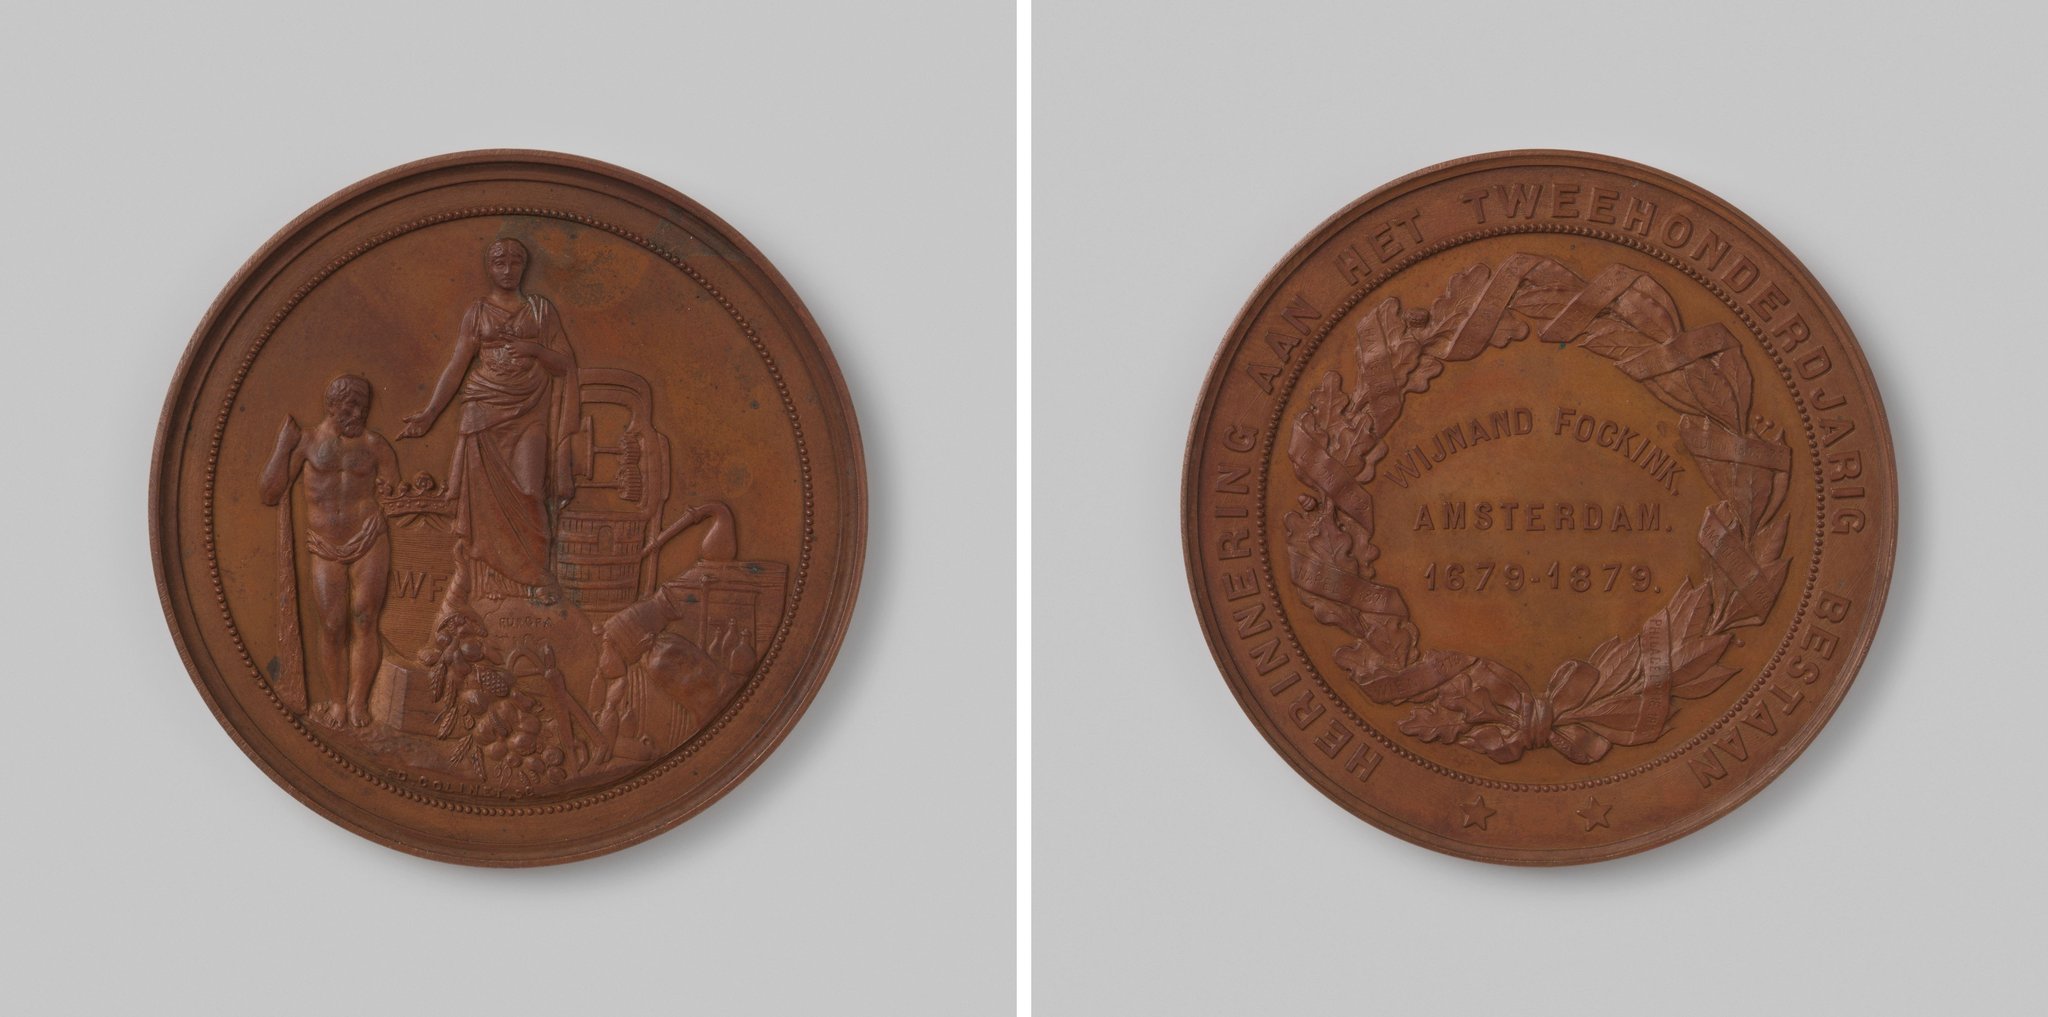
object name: history medal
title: Tweehonderdjarig bestaan van de likeurstokerij van Wijnand Focking te Amsterdam 1879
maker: emmanuel constant edouard colinet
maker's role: sculptor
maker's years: 1844-1890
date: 1879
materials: bronze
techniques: striking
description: Bronzen penning, op de voorzijde een vrouw staand op een wereldbol waartegen een hoorn des overvloeds, links een wildeman met knots en een gekroond schild met WF, en rechts en onder attributen voor de drankbereiding, op de keerzijde drie regels tekst tussen samengestrikte eiken- en lauwertakken waarin verweven een tekstlint, met omschrift.